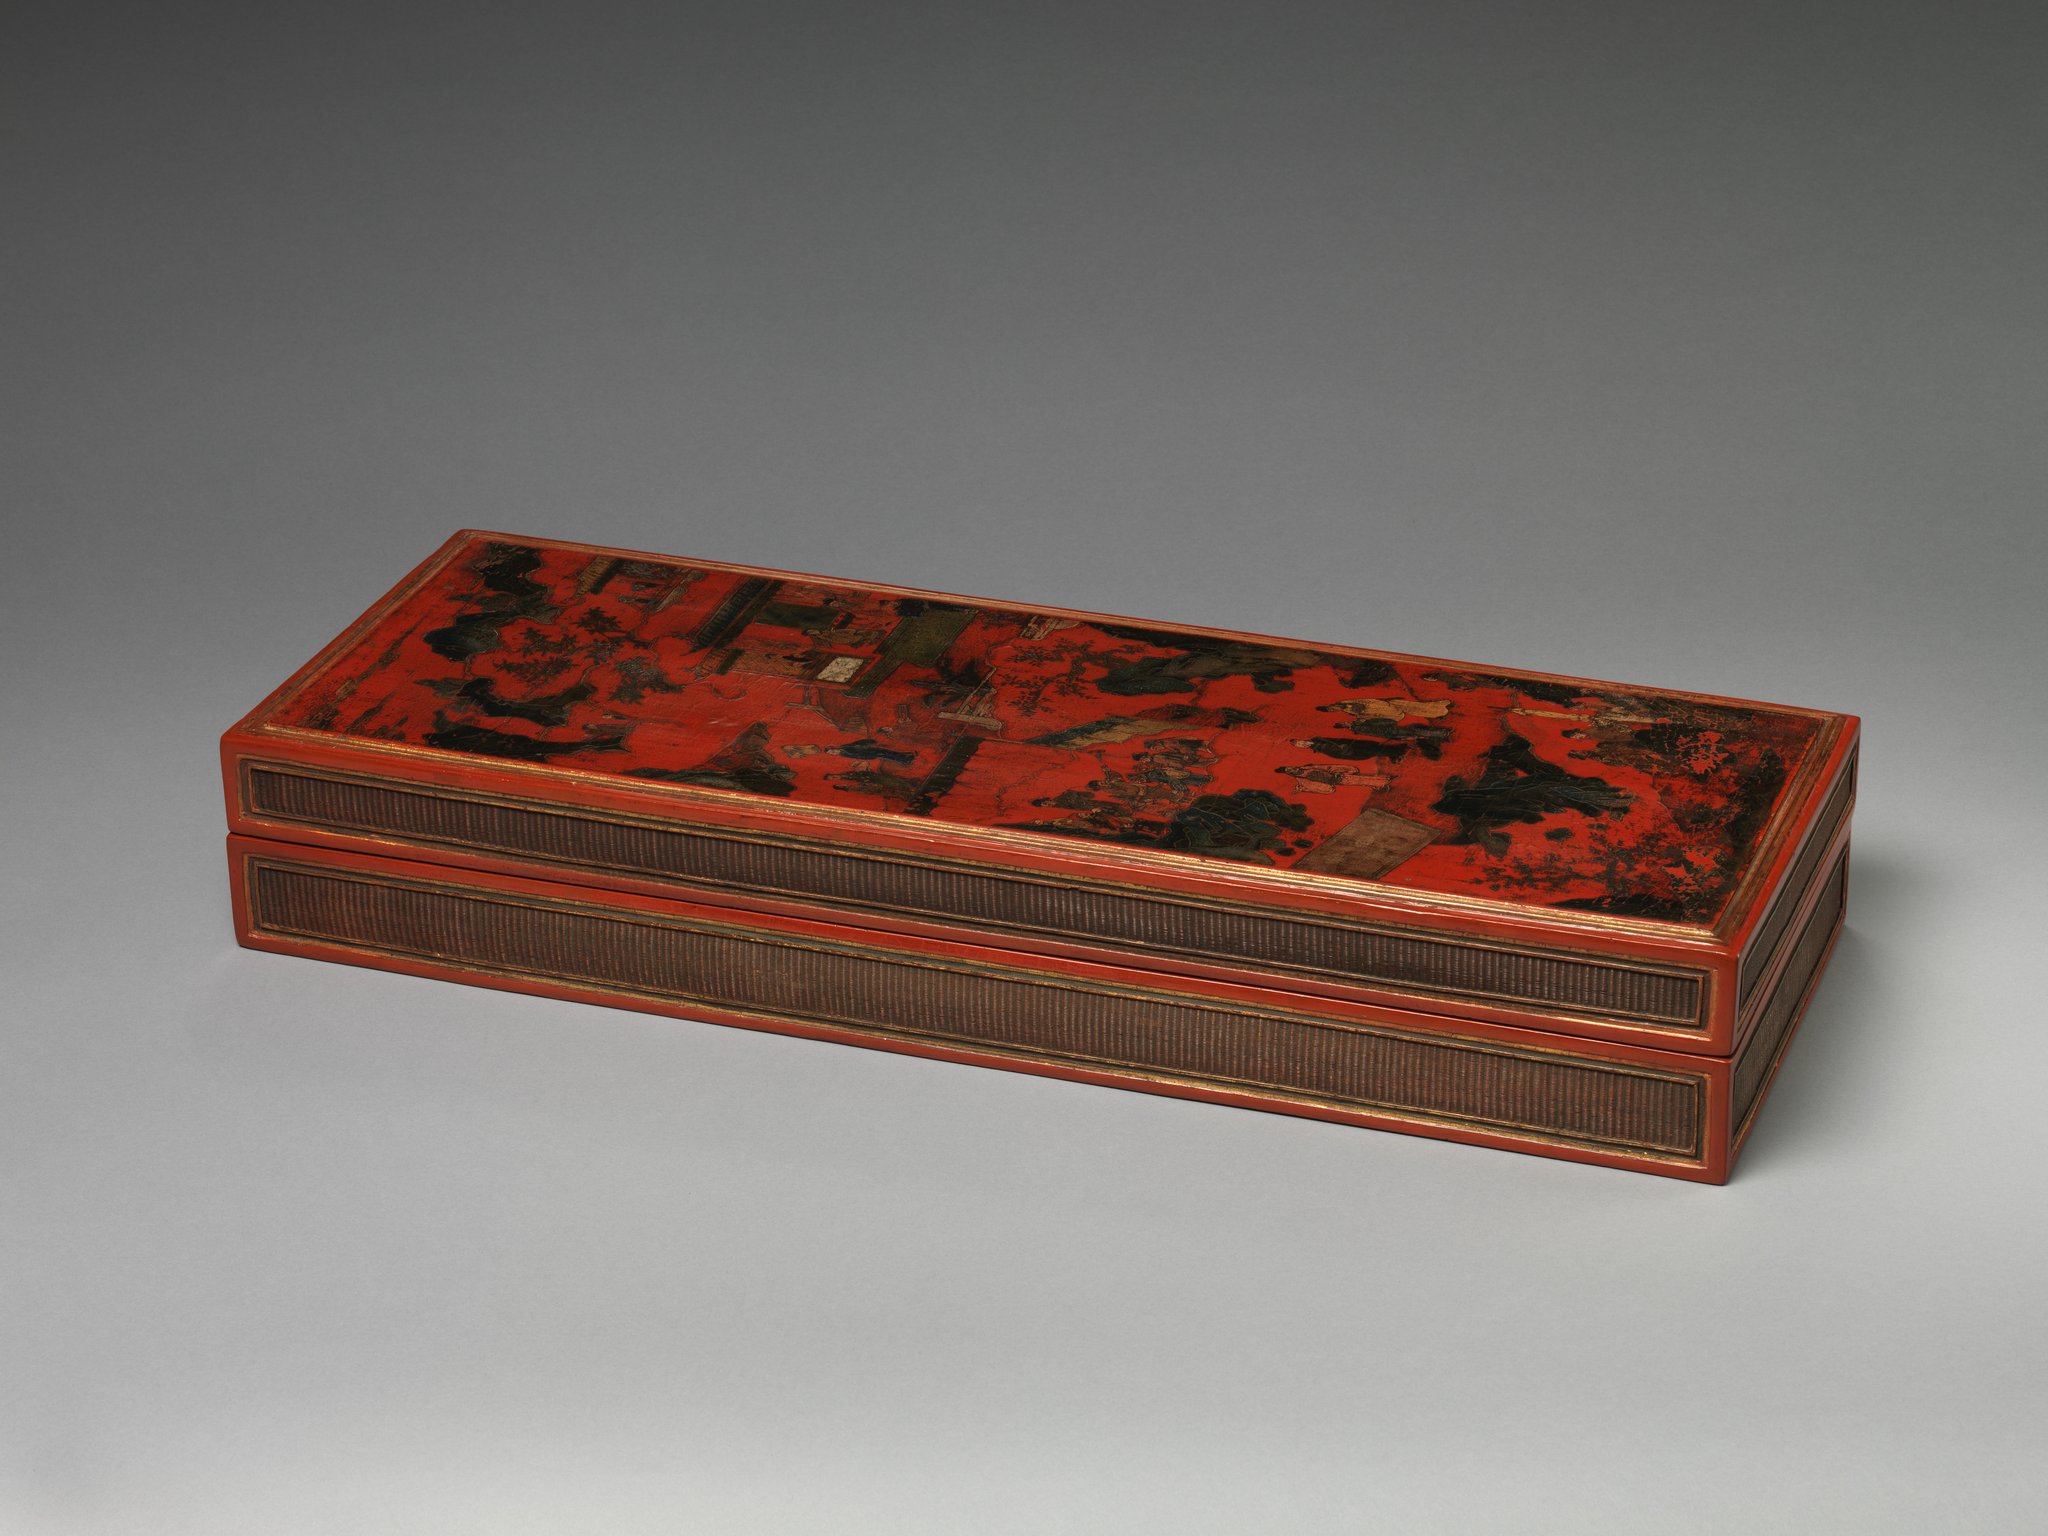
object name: box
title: Rectangular Box with Scene of a Reception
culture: chinese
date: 1601-1700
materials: lacquer, oil, panel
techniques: painting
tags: human figures,houses,trees